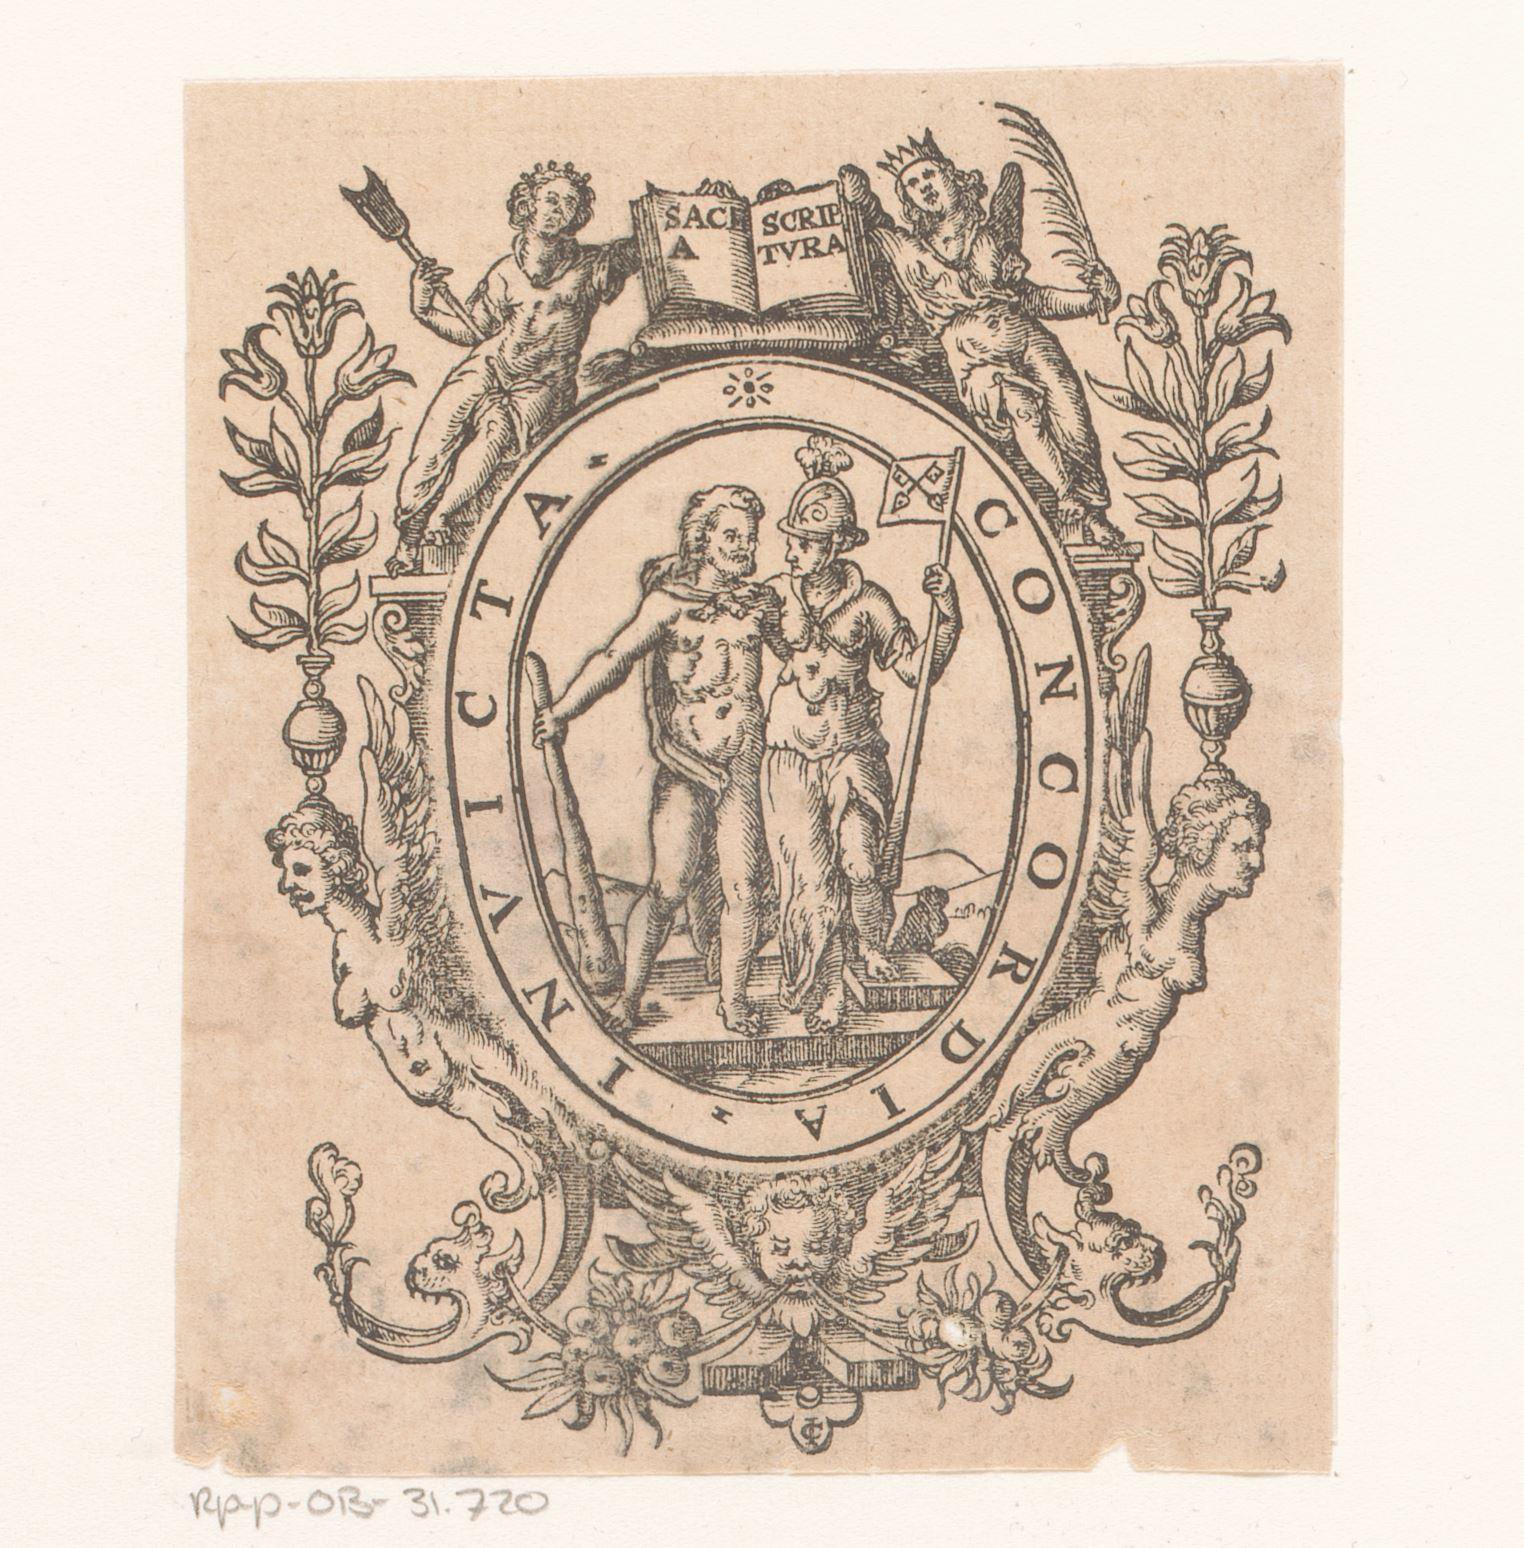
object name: print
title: Vignet met elkaar omhelzende Hercules en Minerva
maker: Anonymous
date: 1600-1699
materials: paper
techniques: woodcut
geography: netherlands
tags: (story of) hercules (heracles), (story of) minerva (pallas, athena), vignette